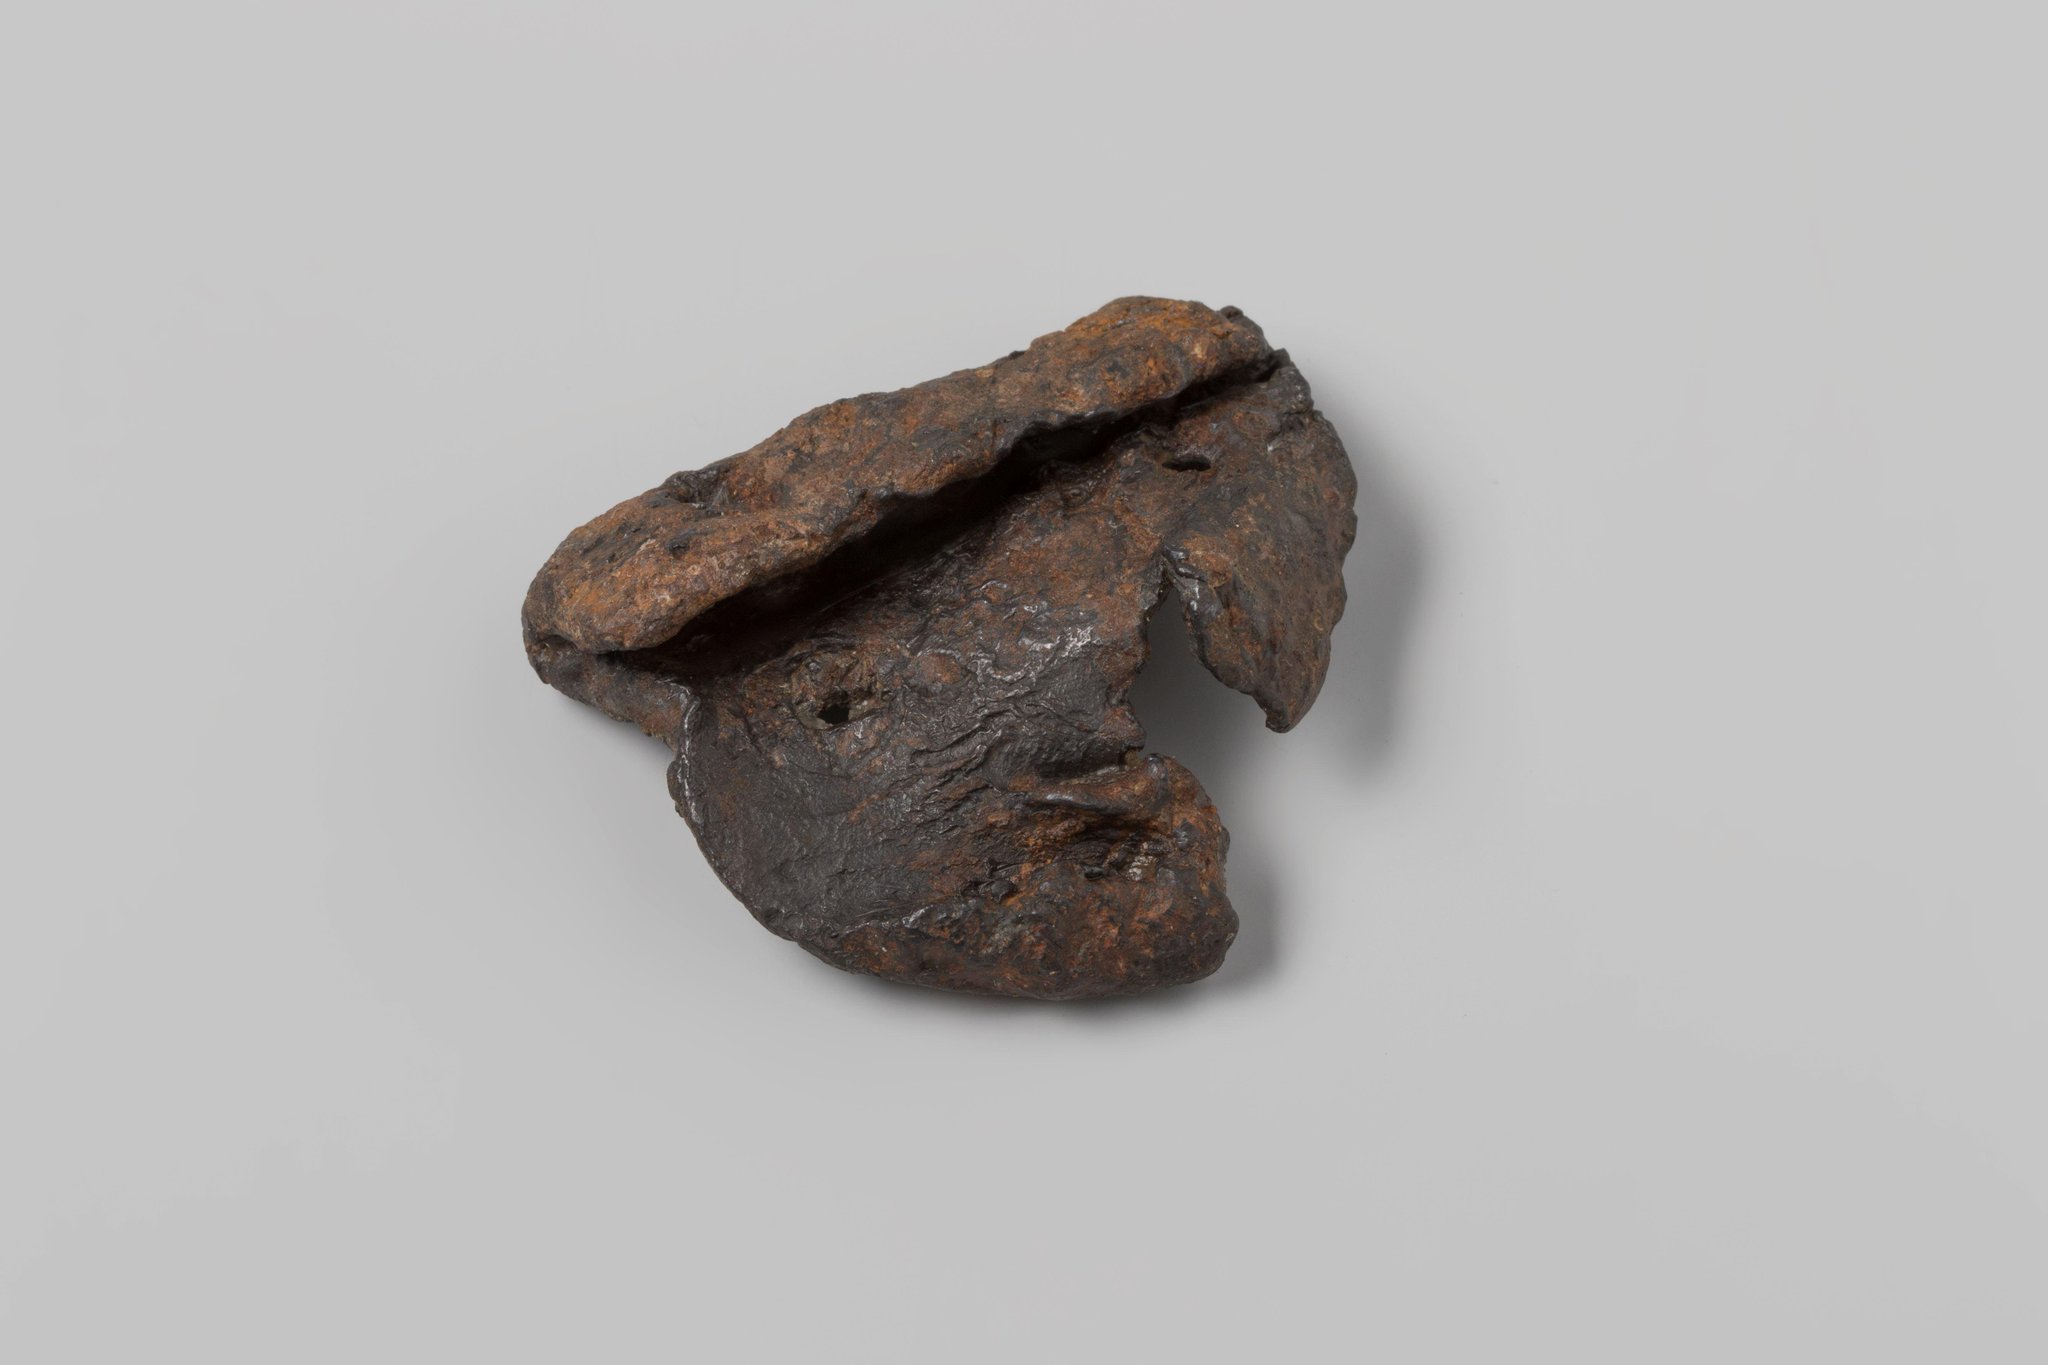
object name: fragment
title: Fragment lood uit het wrak van de Oost-Indiëvaarder Hollandia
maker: Anonymous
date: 1700-1743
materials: lead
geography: netherlands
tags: verenigde oostindische compagnie, hollandia (schip), annet